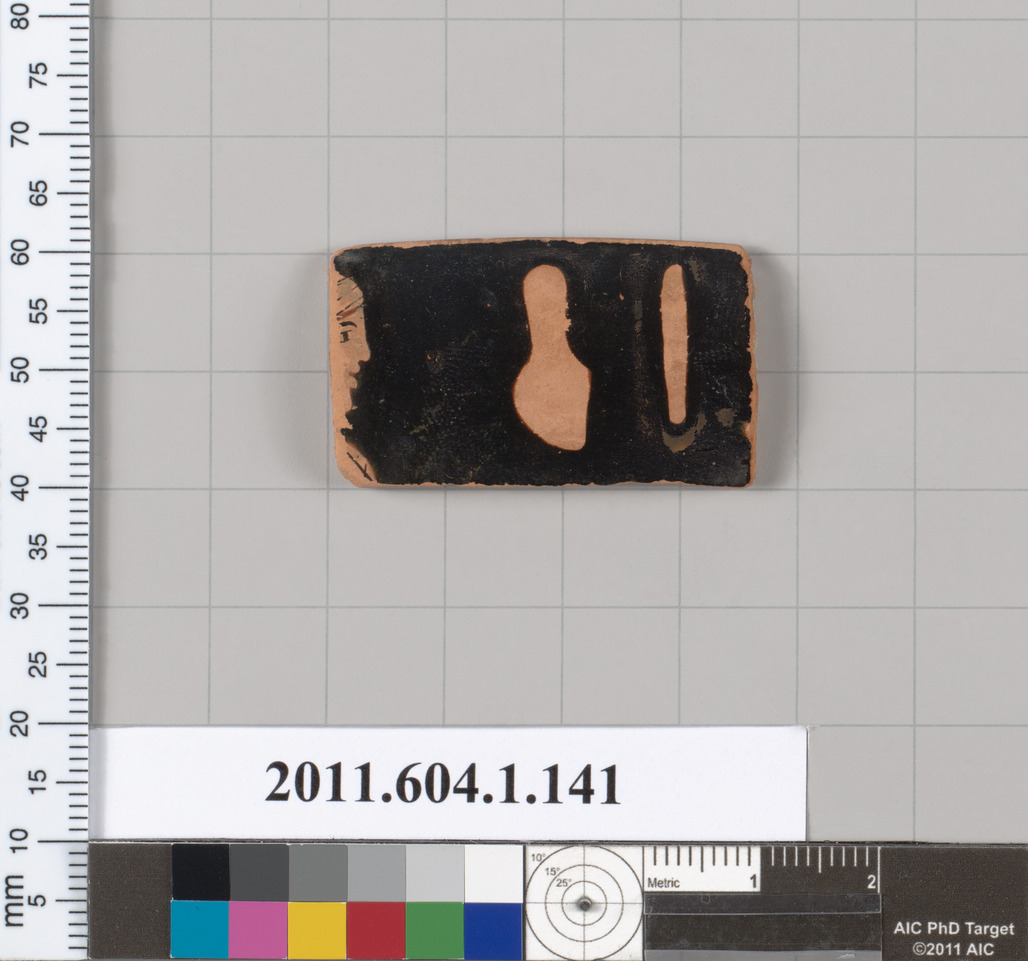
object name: kylix fragment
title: Terracotta rim fragment of a kylix (drinking cup)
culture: greek, attic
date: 475-451 BCE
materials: terracotta